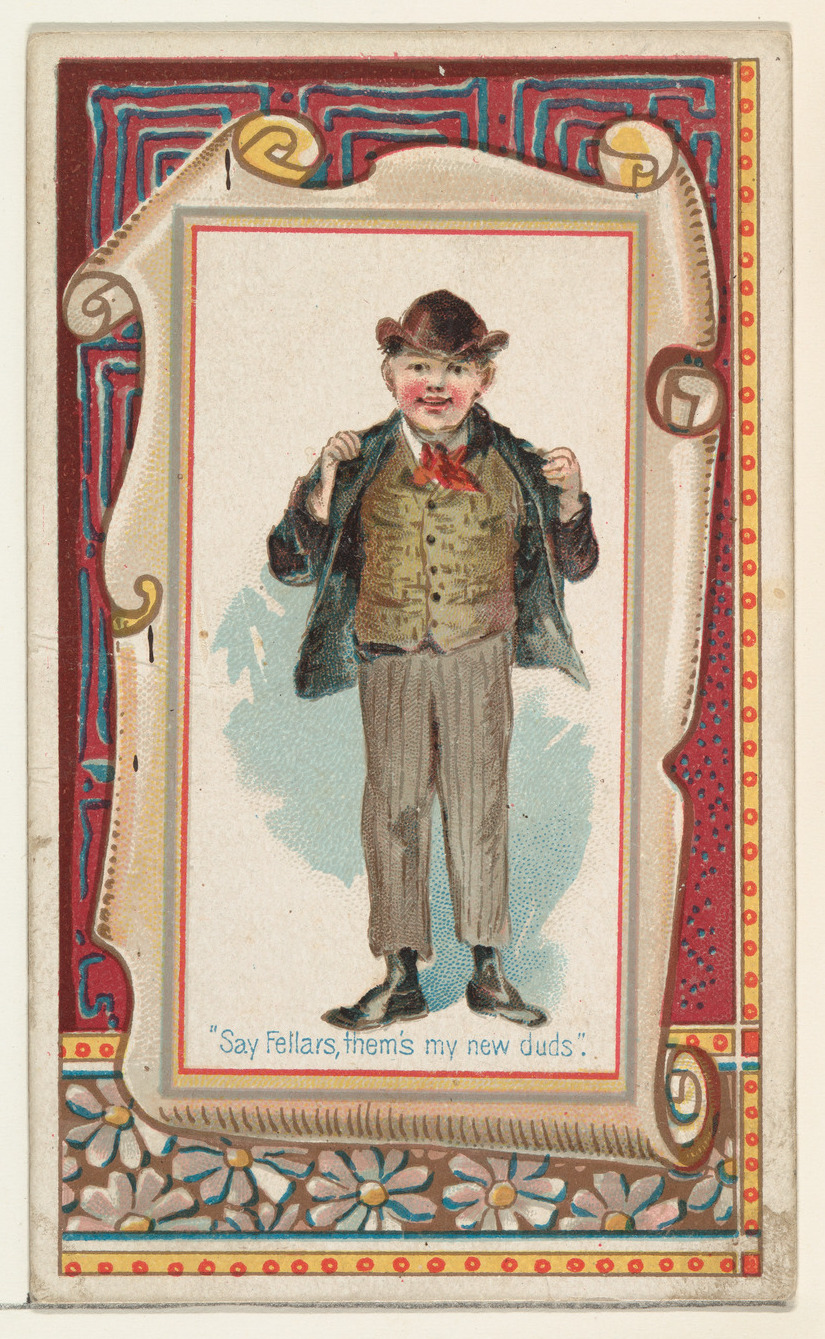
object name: print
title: "Say Fellars, them's my new duds," from the Terrors of America set (N136) issued by Duke Sons & Co. to promote Honest Long Cut Tobacco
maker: w. duke, sons & co.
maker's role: publisher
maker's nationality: american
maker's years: 1870-1920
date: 1888-1889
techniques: color lithograph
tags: boys